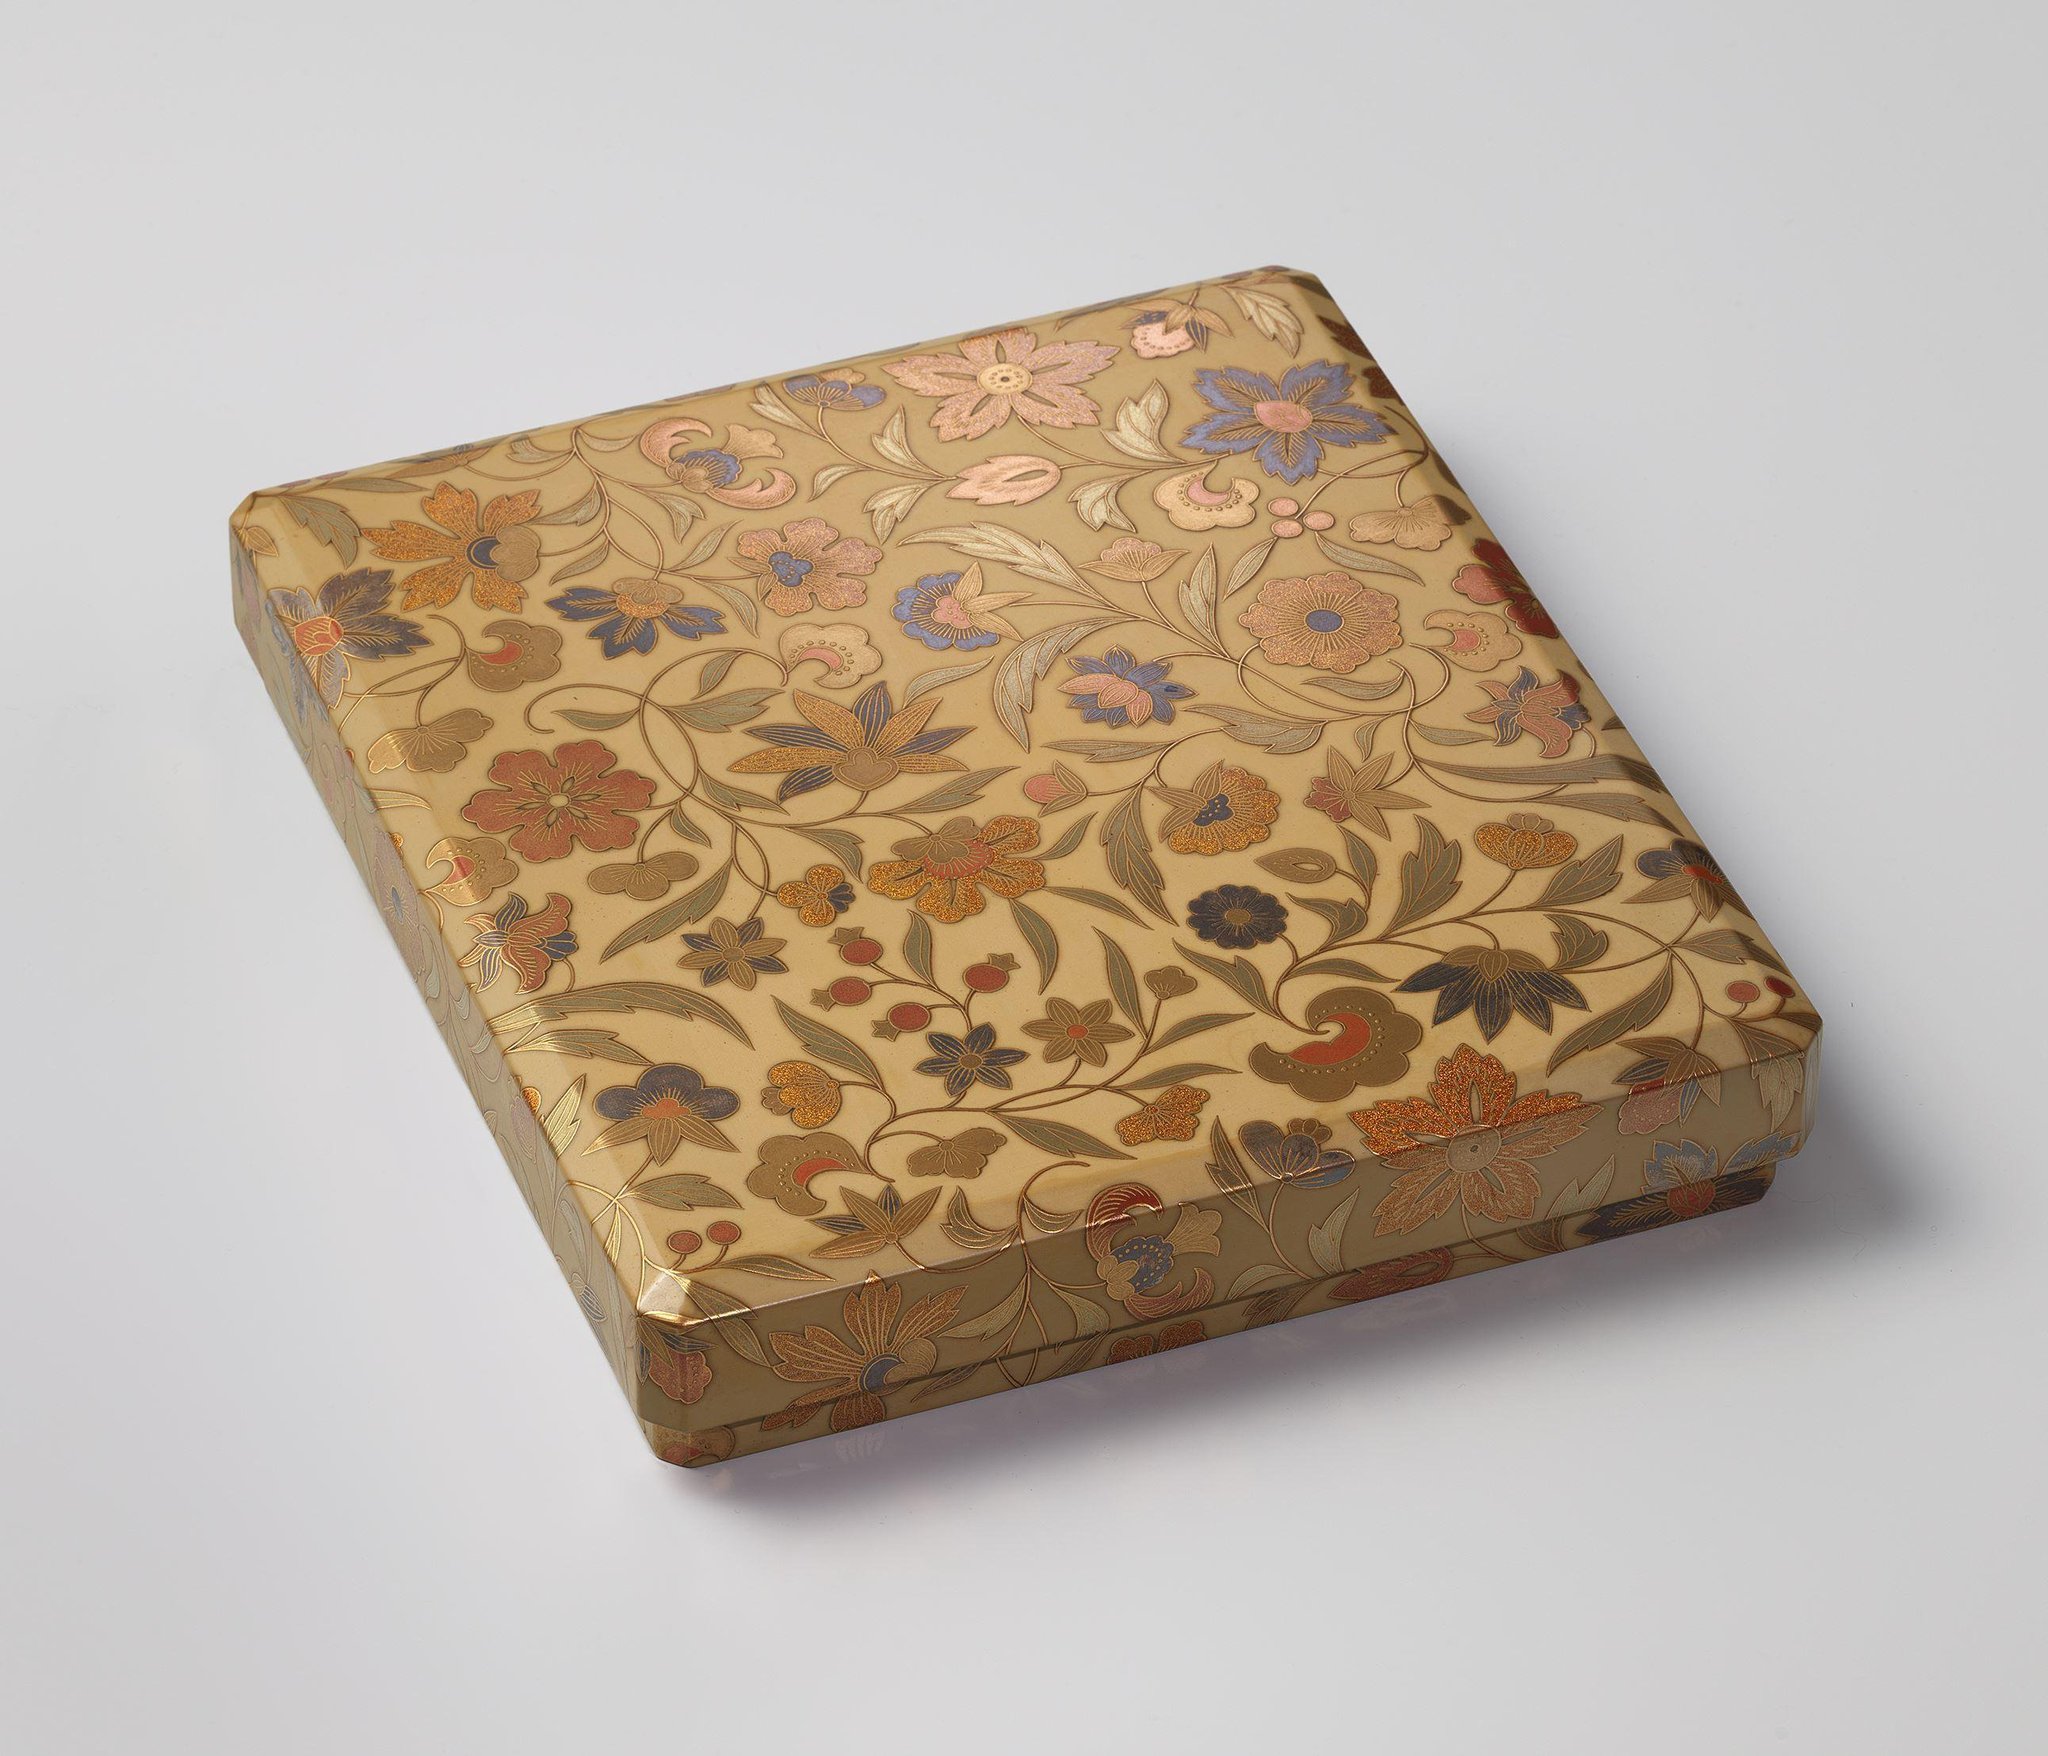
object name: schrijfdoos, schrijfcassette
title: Writing Box with a Chintz Pattern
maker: inai guokuho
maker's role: lacquerer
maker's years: 1876-1930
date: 1910-1925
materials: lacquer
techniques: lacquer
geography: japan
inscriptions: inscription: ‘白漆地更紗模様硯箱’, inscription: ‘京都稲井玉甫’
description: The graceful pattern on this box is derived from the colourful, woodblock-printed fabric (chintz, in Japanese sarasa), which the Dutch East India Company had brought to Japan in previous centuries. The cream-coloured ground reflects the natural colour of the cotton cloth. As white lacquer could not yet be produced, Gyokuho used ground shells for this.